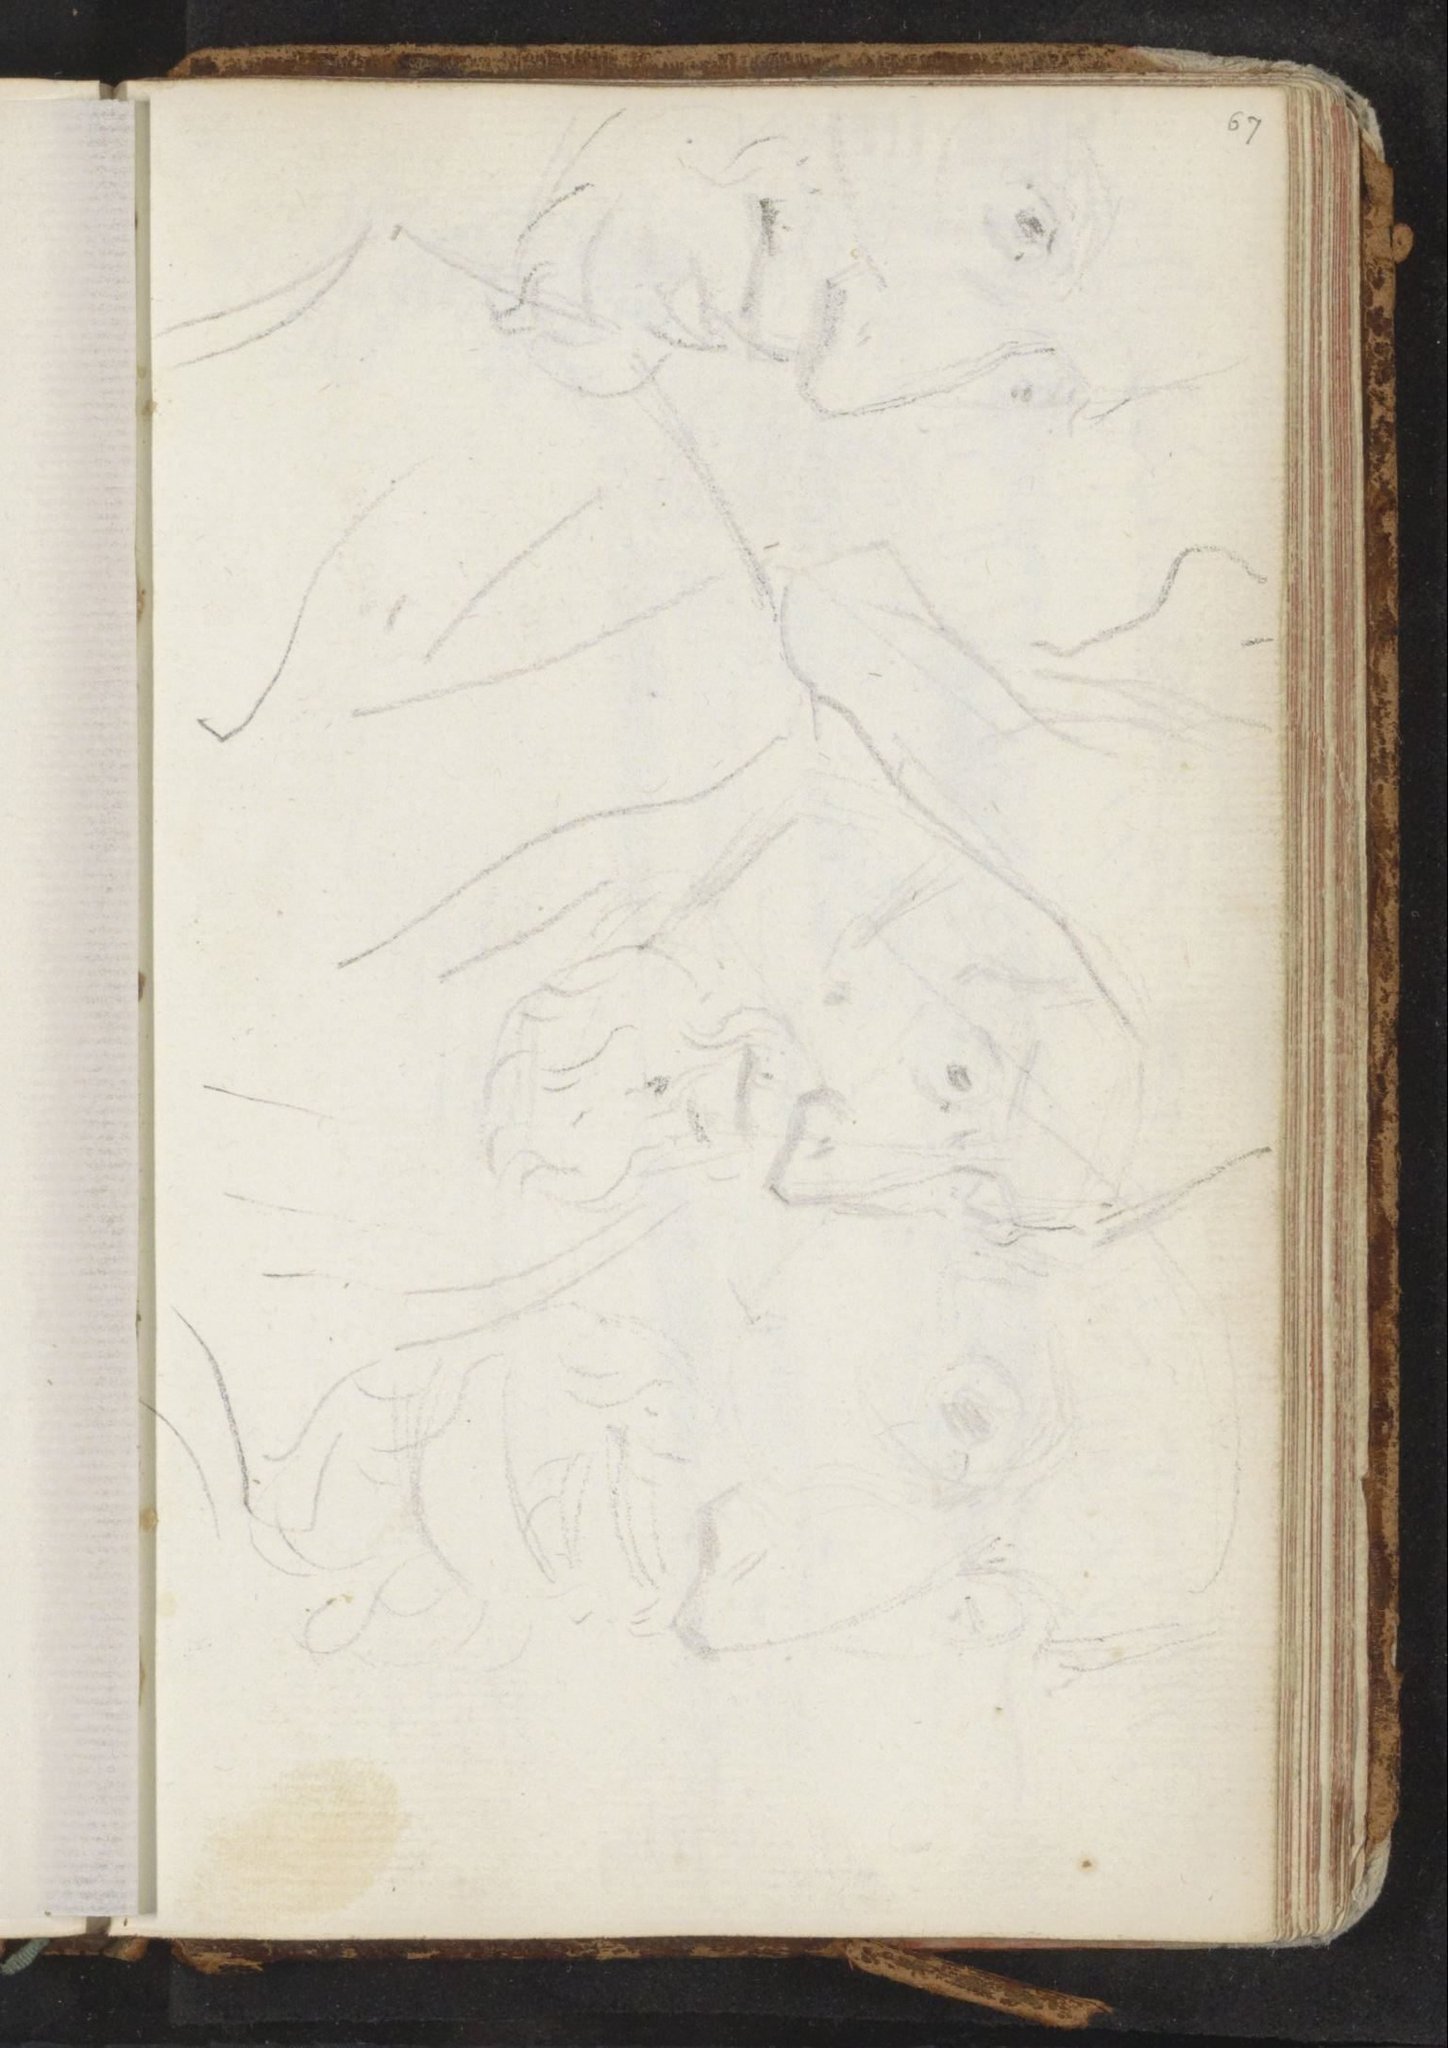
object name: sketchbook leaf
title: Koppen van een man met een baard en muts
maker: jean honoré fragonard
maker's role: draughtsman, painter, print maker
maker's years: 1732-1806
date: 1765-1775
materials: paper, pencil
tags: head (human), beard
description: Blad 67 recto uit een schetsboek met 83 bladen.